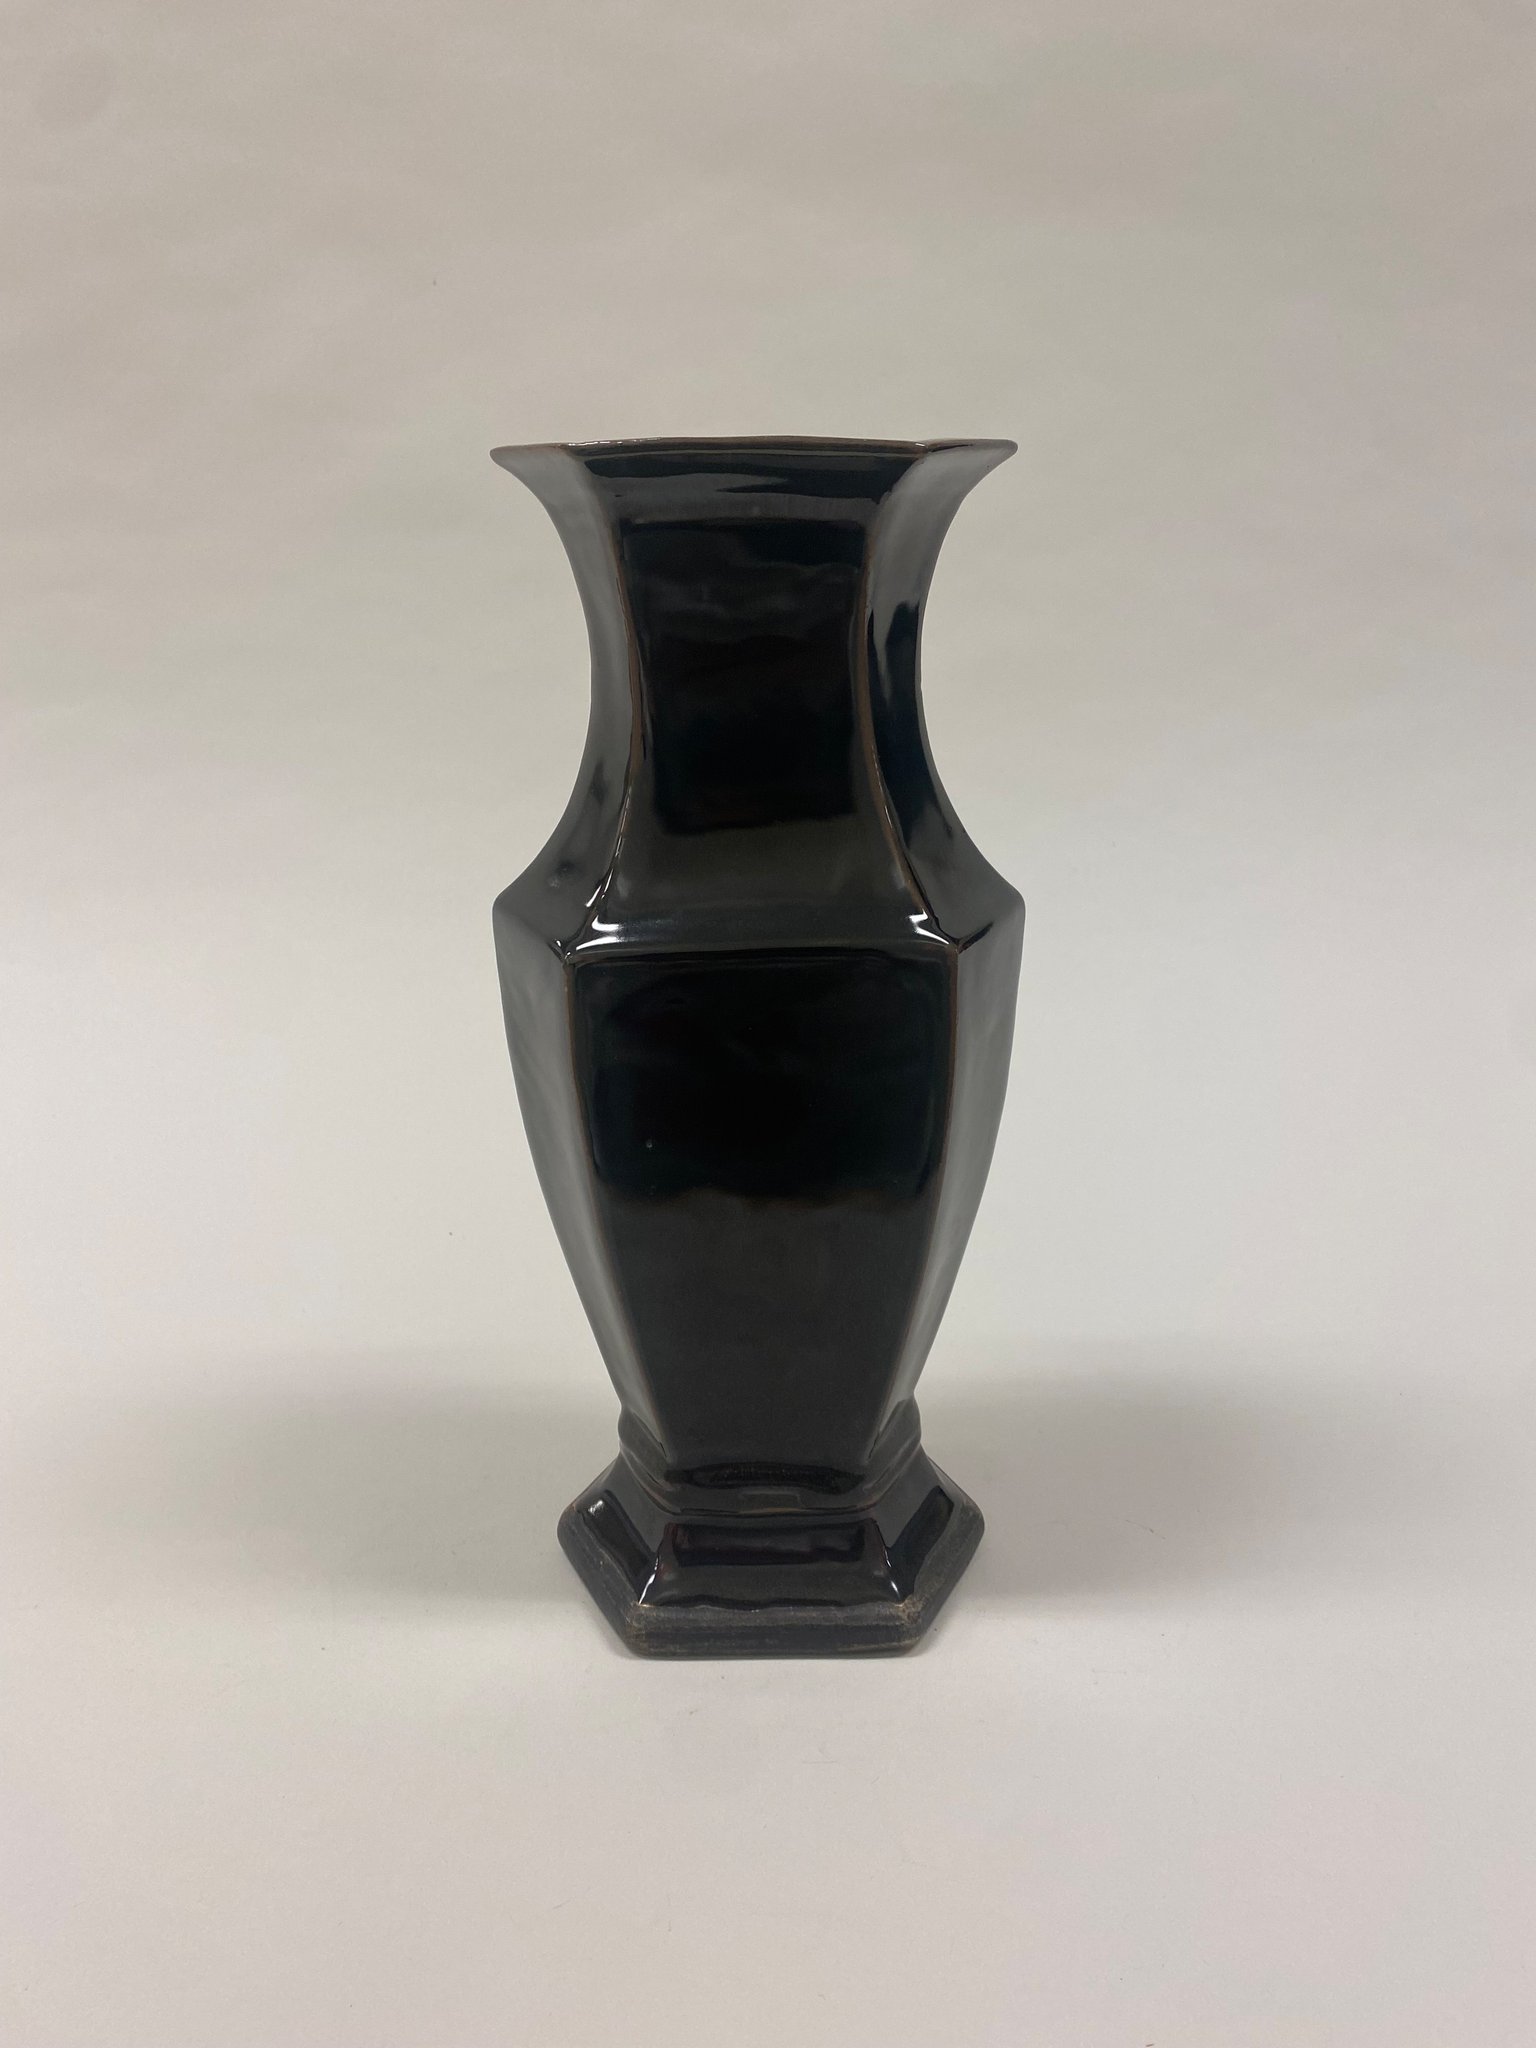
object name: vase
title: Hexagonal vase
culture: chinese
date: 1767-1833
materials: porcelain